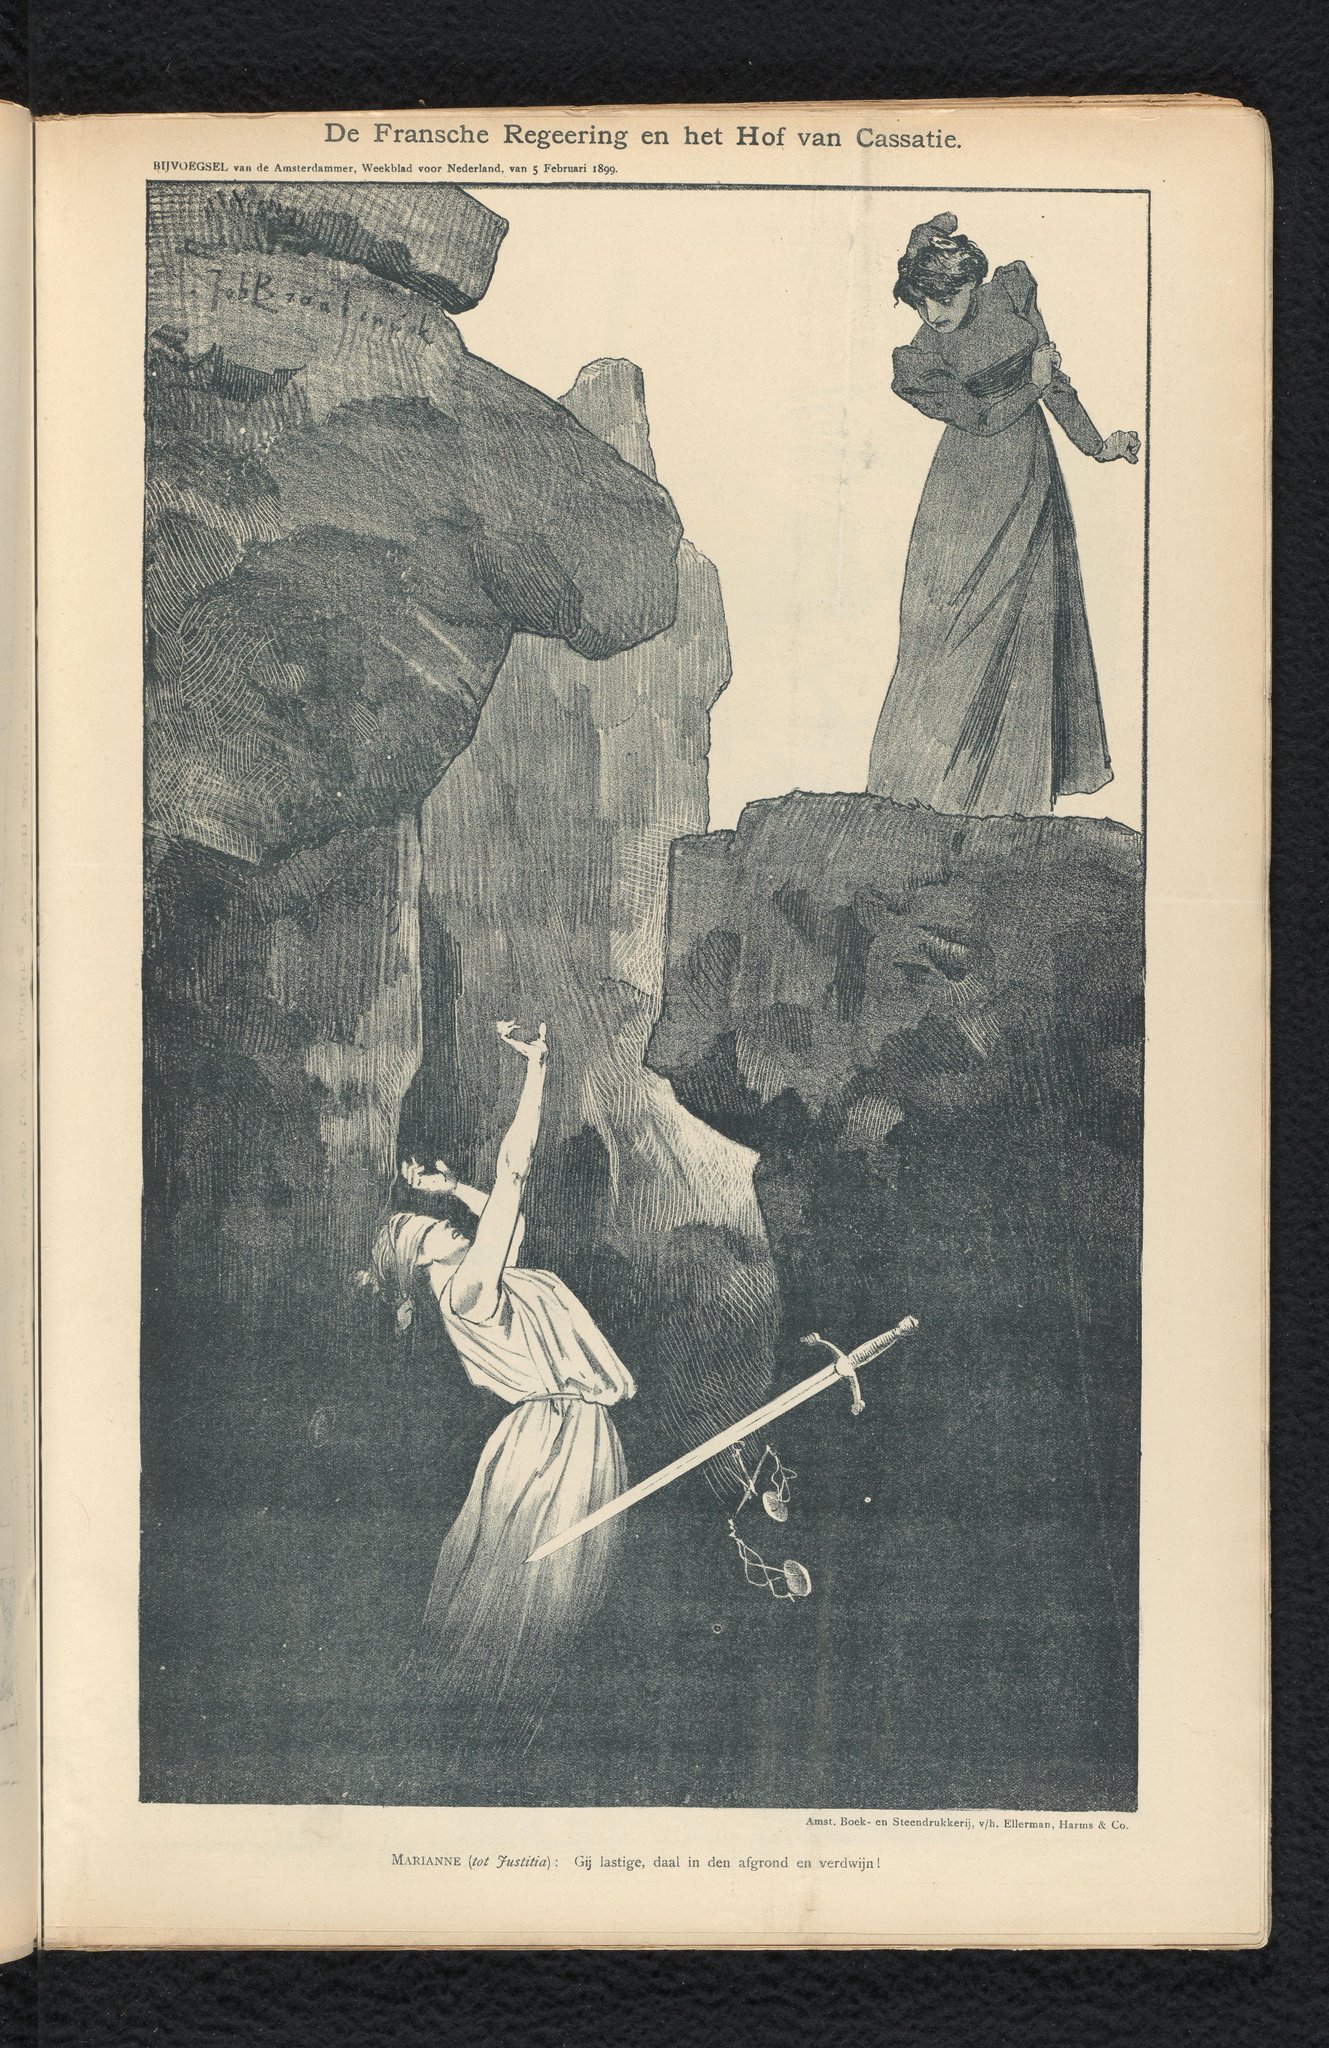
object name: cartoon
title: De Fransche Regeering en het Hof van Cassatie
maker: johan braakensiek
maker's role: draughtsman, print maker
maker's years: 1858-1940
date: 1899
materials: paper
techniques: lithograph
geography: netherlands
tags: justice, 'justitia'; 'giustitia divina' (ripa) ~ one of the four cardinal virtues, personifications of countries, nations, states, districts, etc., political caricatures and satires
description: Marianne (Frankrijk) werpt Justitia in de afgrond. Naar aanleiding van het beroep bij het Hof van Cassatie in de Dreyfusaffaire.